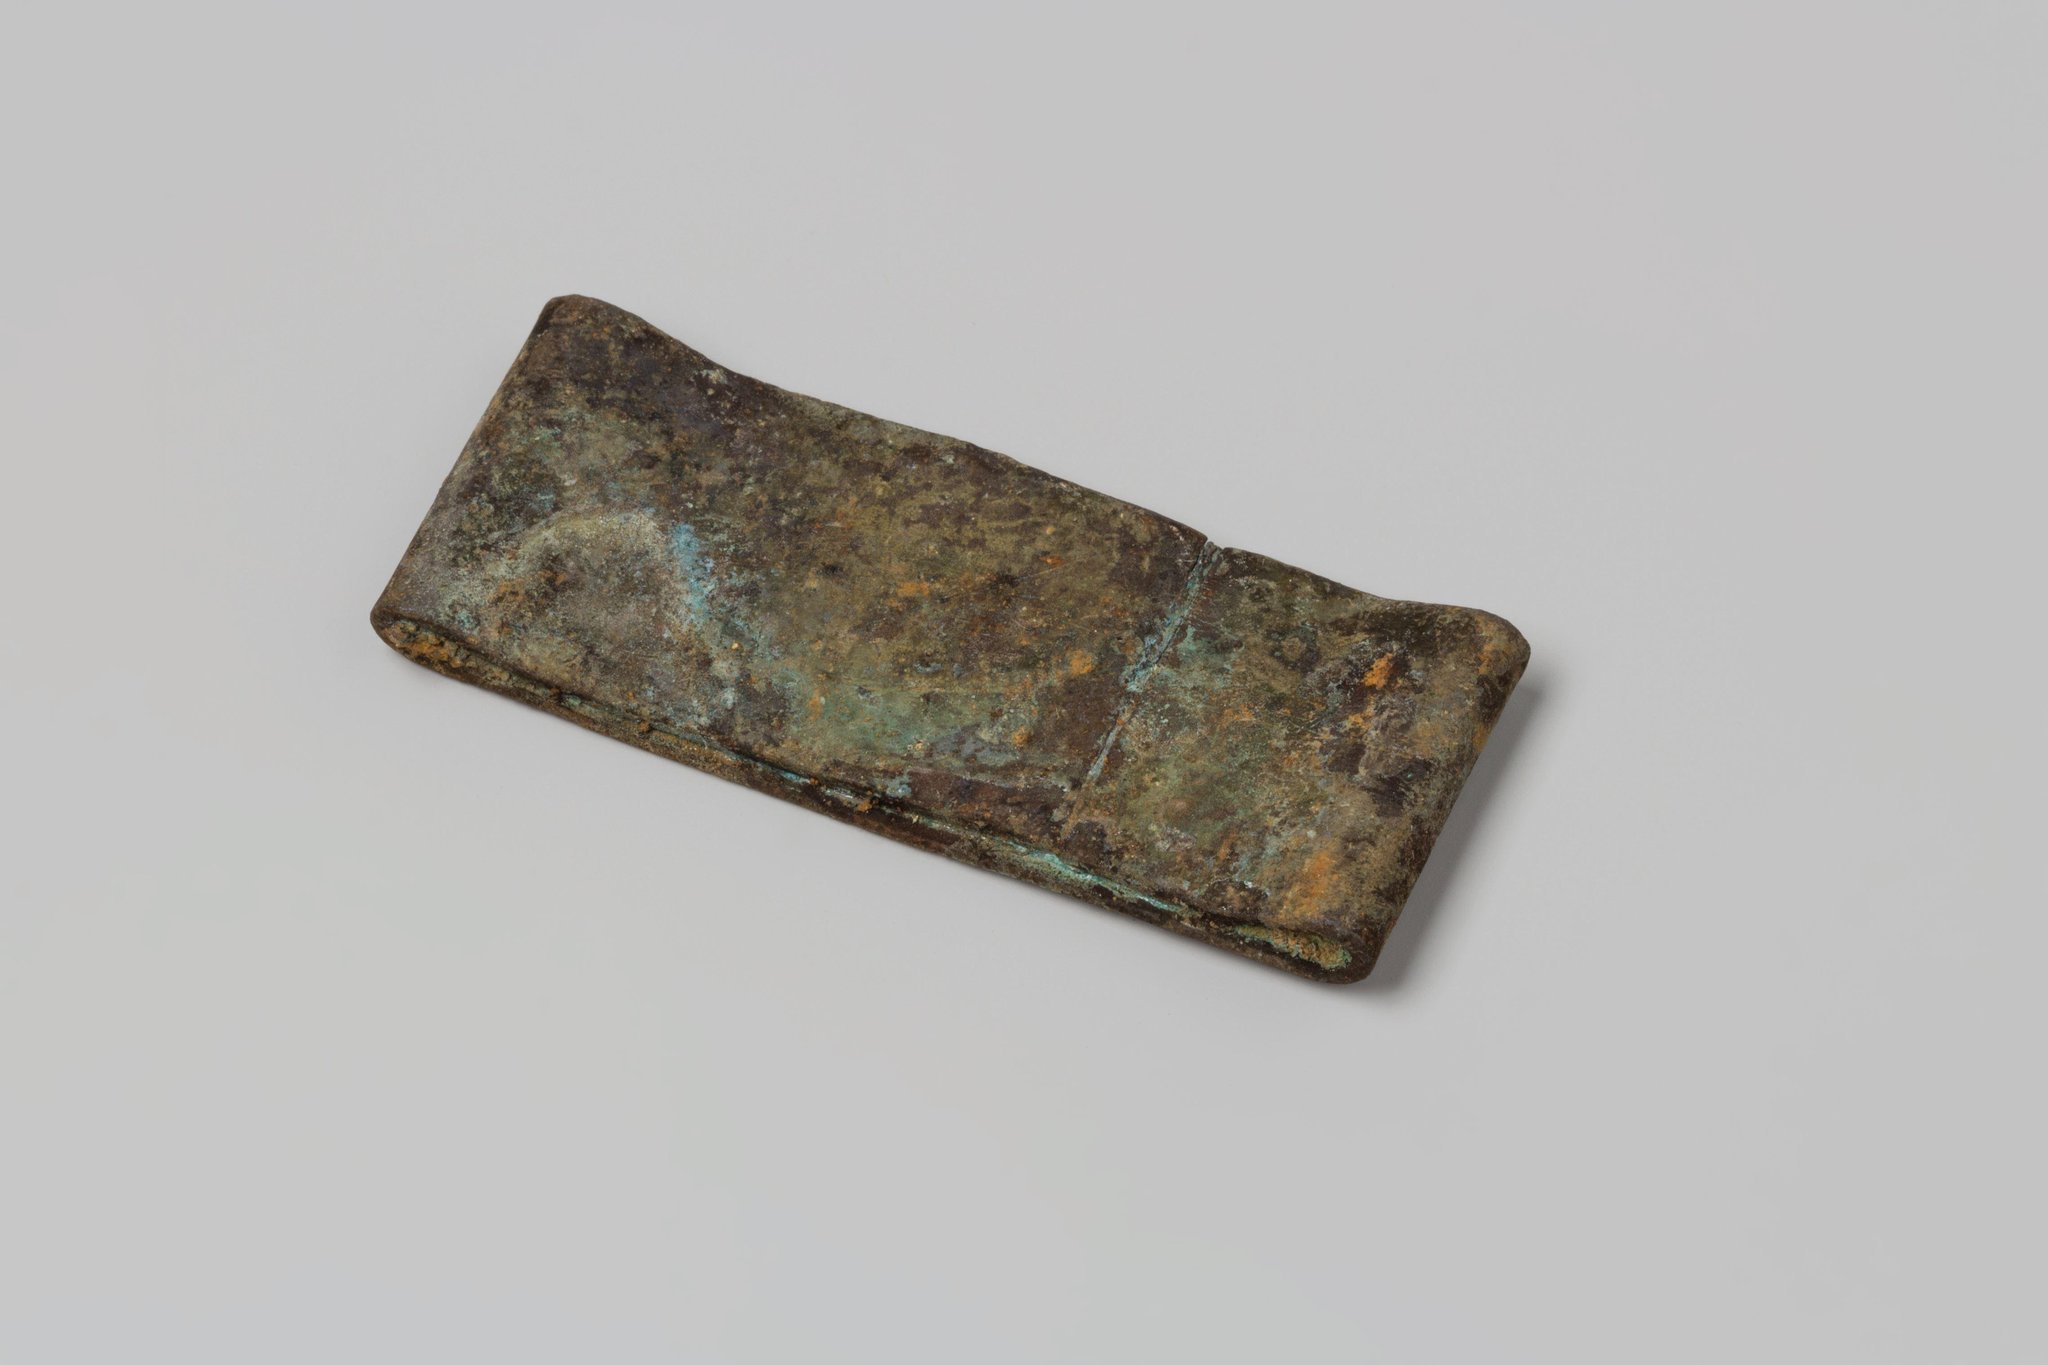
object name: firehose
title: Brandslangring uit het wrak van de Oost-Indiëvaarder Hollandia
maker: Anonymous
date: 1700-1743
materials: copper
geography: netherlands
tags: verenigde oostindische compagnie, hollandia (schip), annet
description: Firehose, fragm, id. NG 1975-20H1271a, squashed.